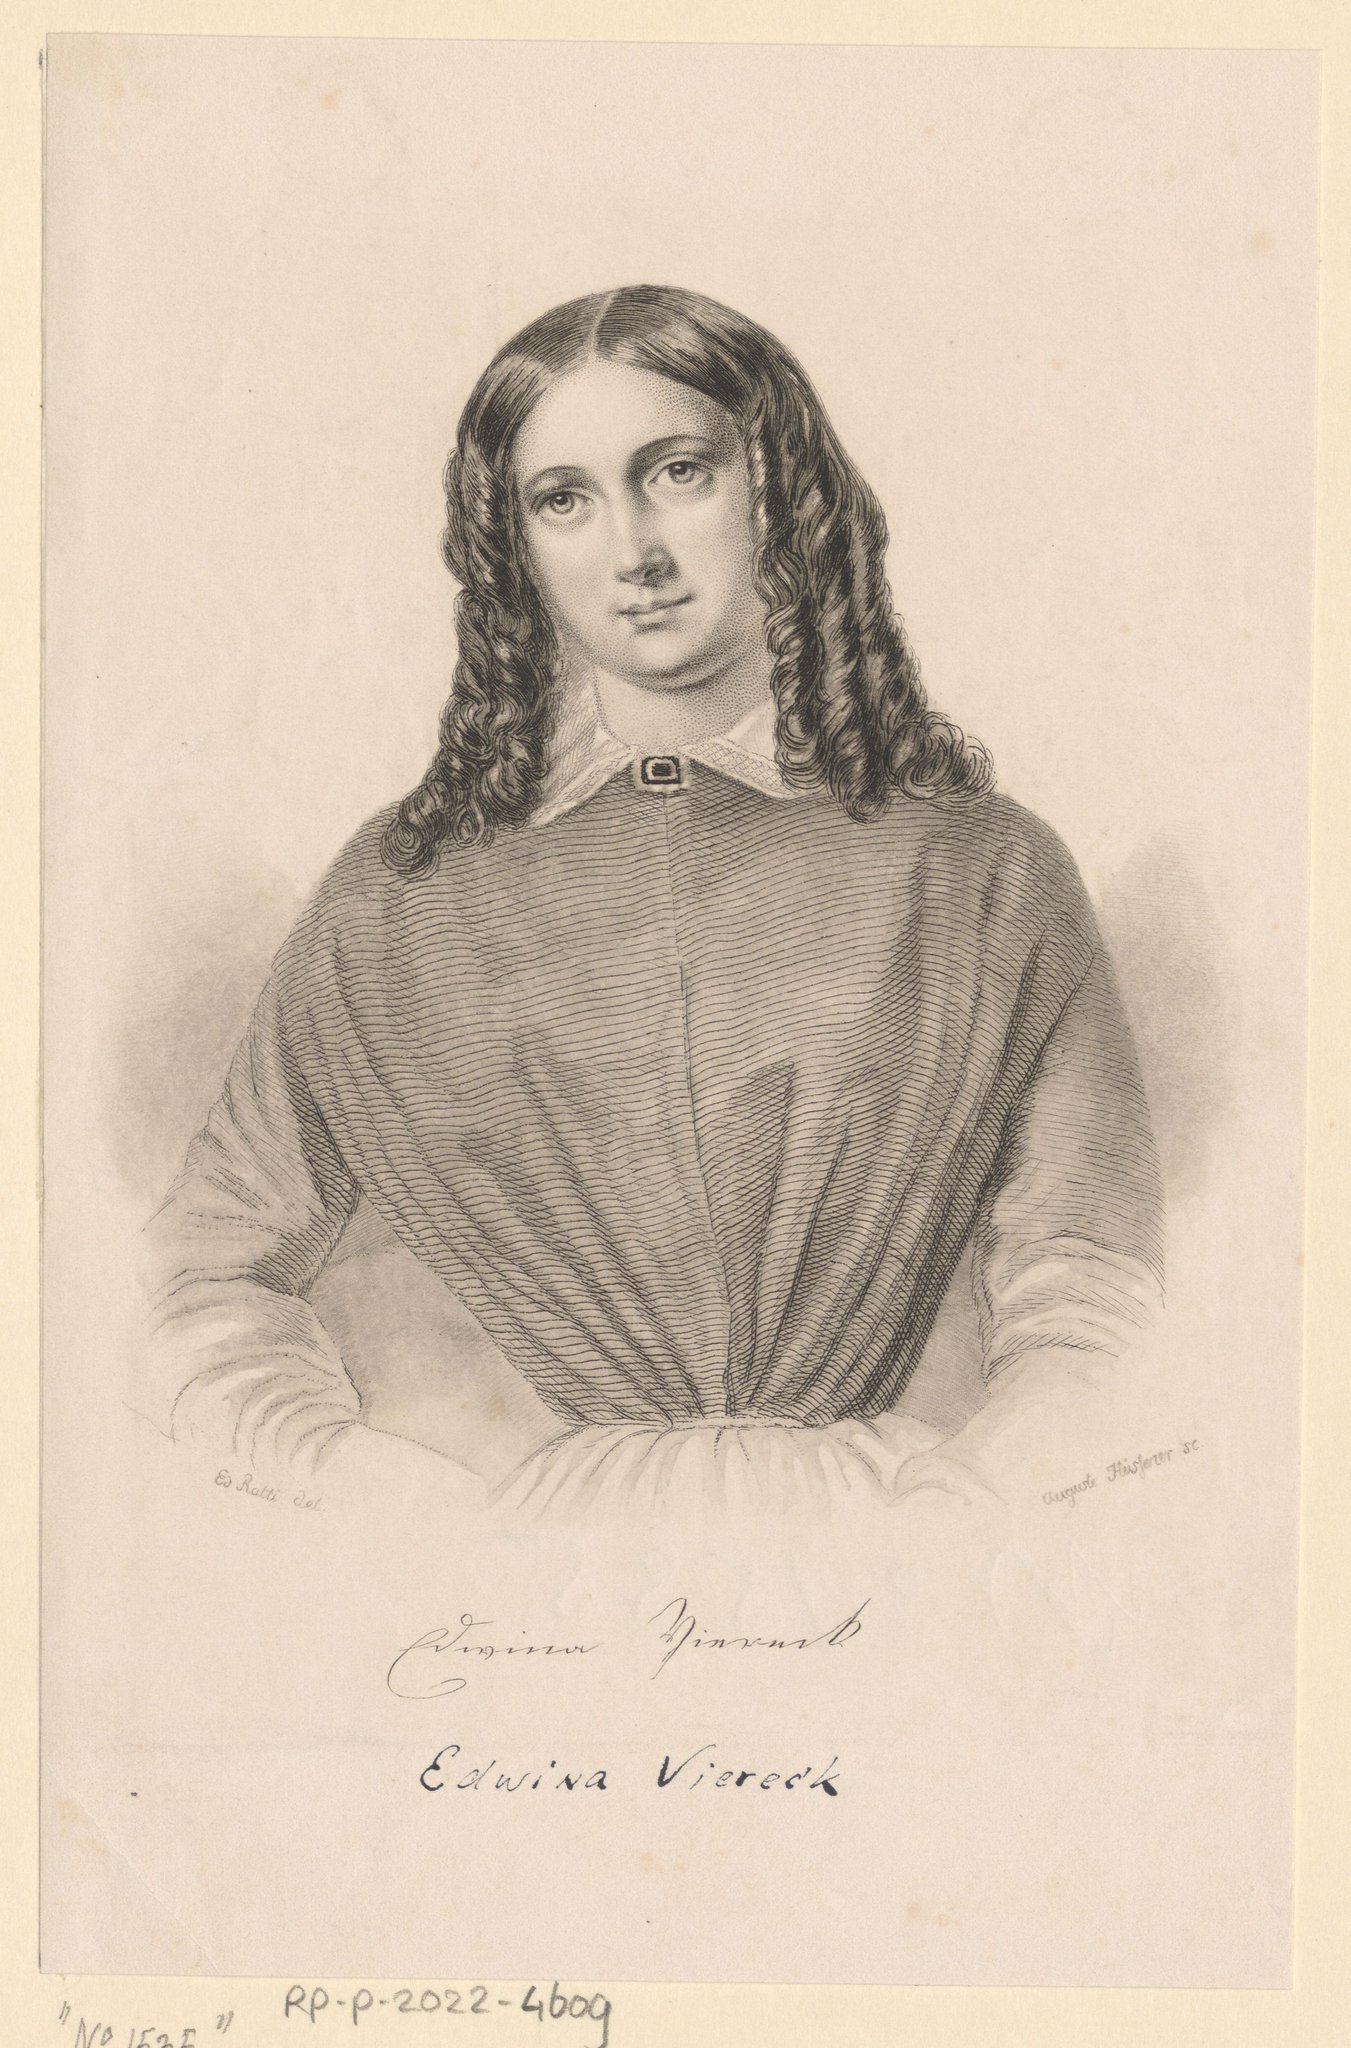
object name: print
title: Portret van Edwina Viereck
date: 1840-1877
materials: paper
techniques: etching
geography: germany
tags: historical persons, portrait of actor, actress